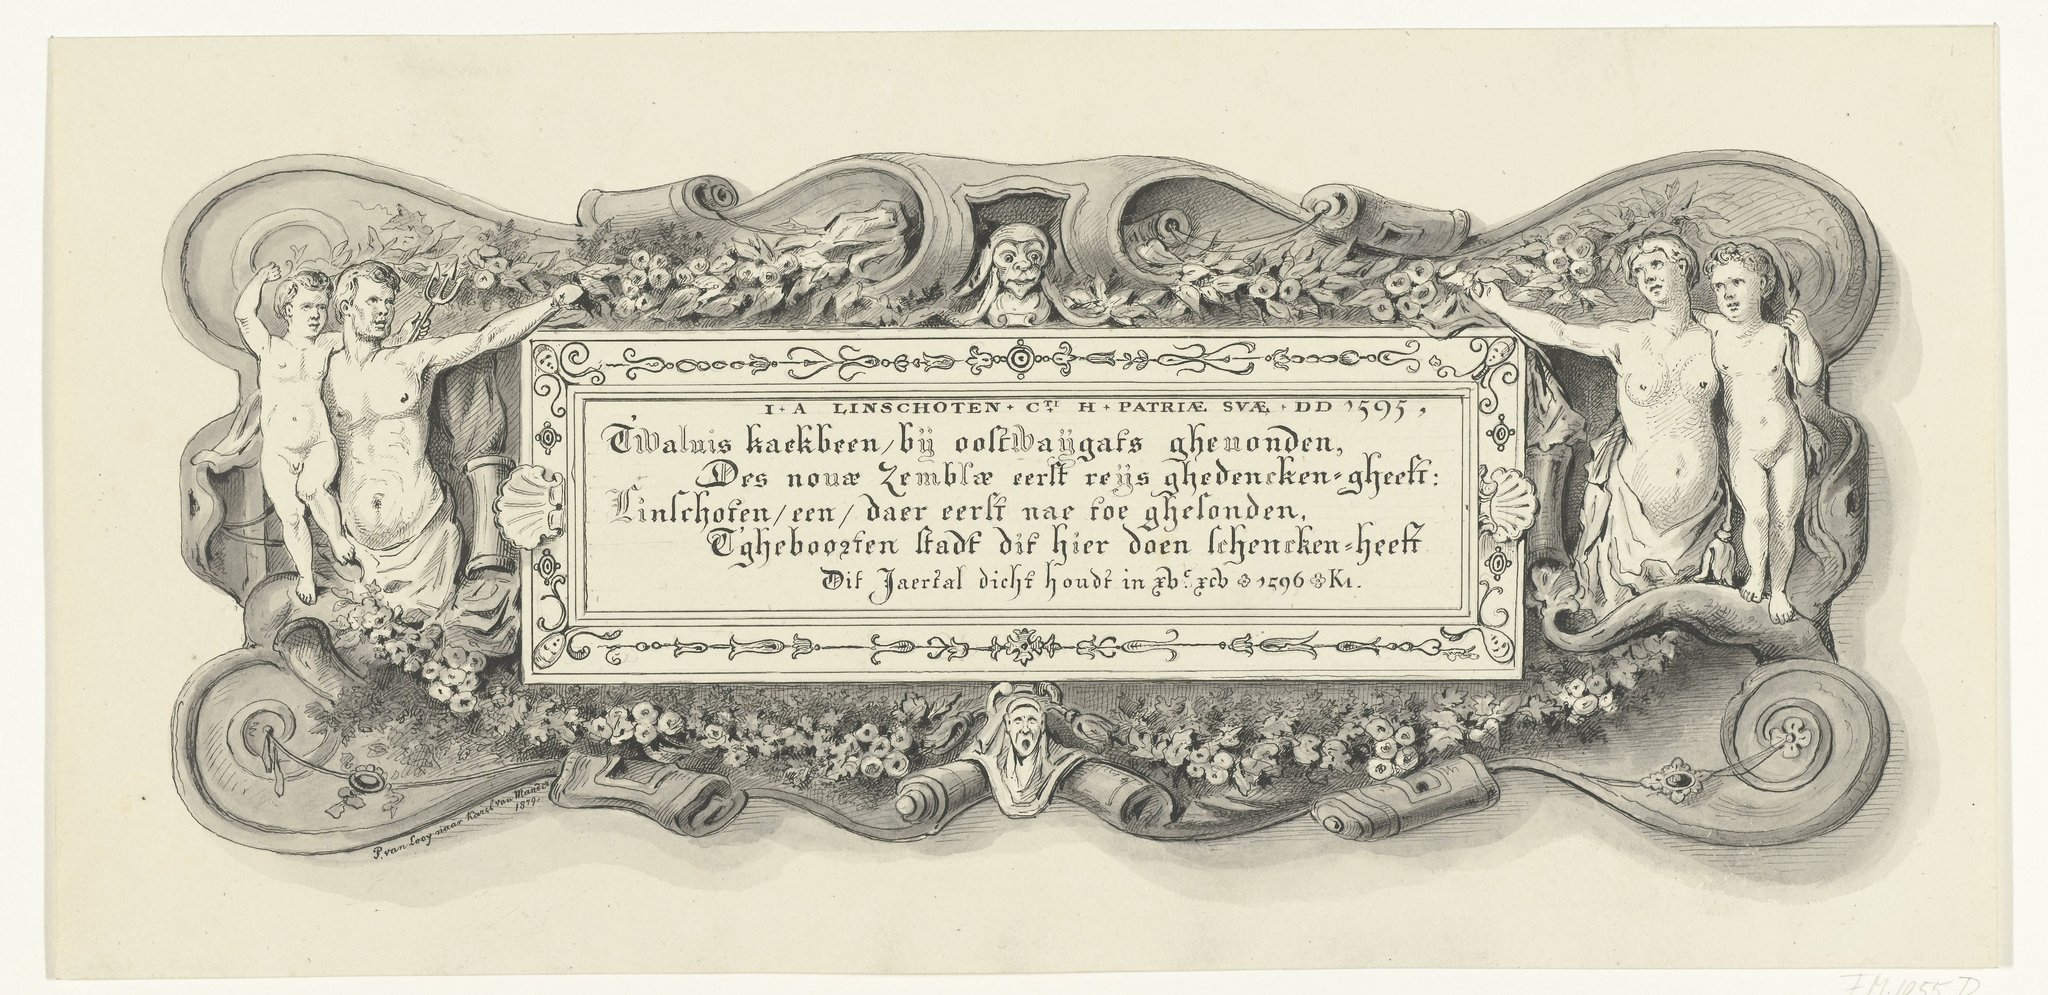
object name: historical object representation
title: Plaque met vers op het walvisbeen van Jan Huygen van Linschoten in het stadhuis van Haarlem, 1596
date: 1879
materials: ink, paper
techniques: brush, pen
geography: netherlands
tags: jan huygen van linschoten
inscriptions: date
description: Plaque met vers van vier regels behorend bij het walvisbeen teruggebracht door Jan Huygen van Linschoten van zijn reis naar het noorden in 1595 en in 1596 geschonken aan zijn geboortestad, bewaard op het stadhuis van Haarlem. Plaque versierd met menselijke figuren, festoenen en rolwerk.